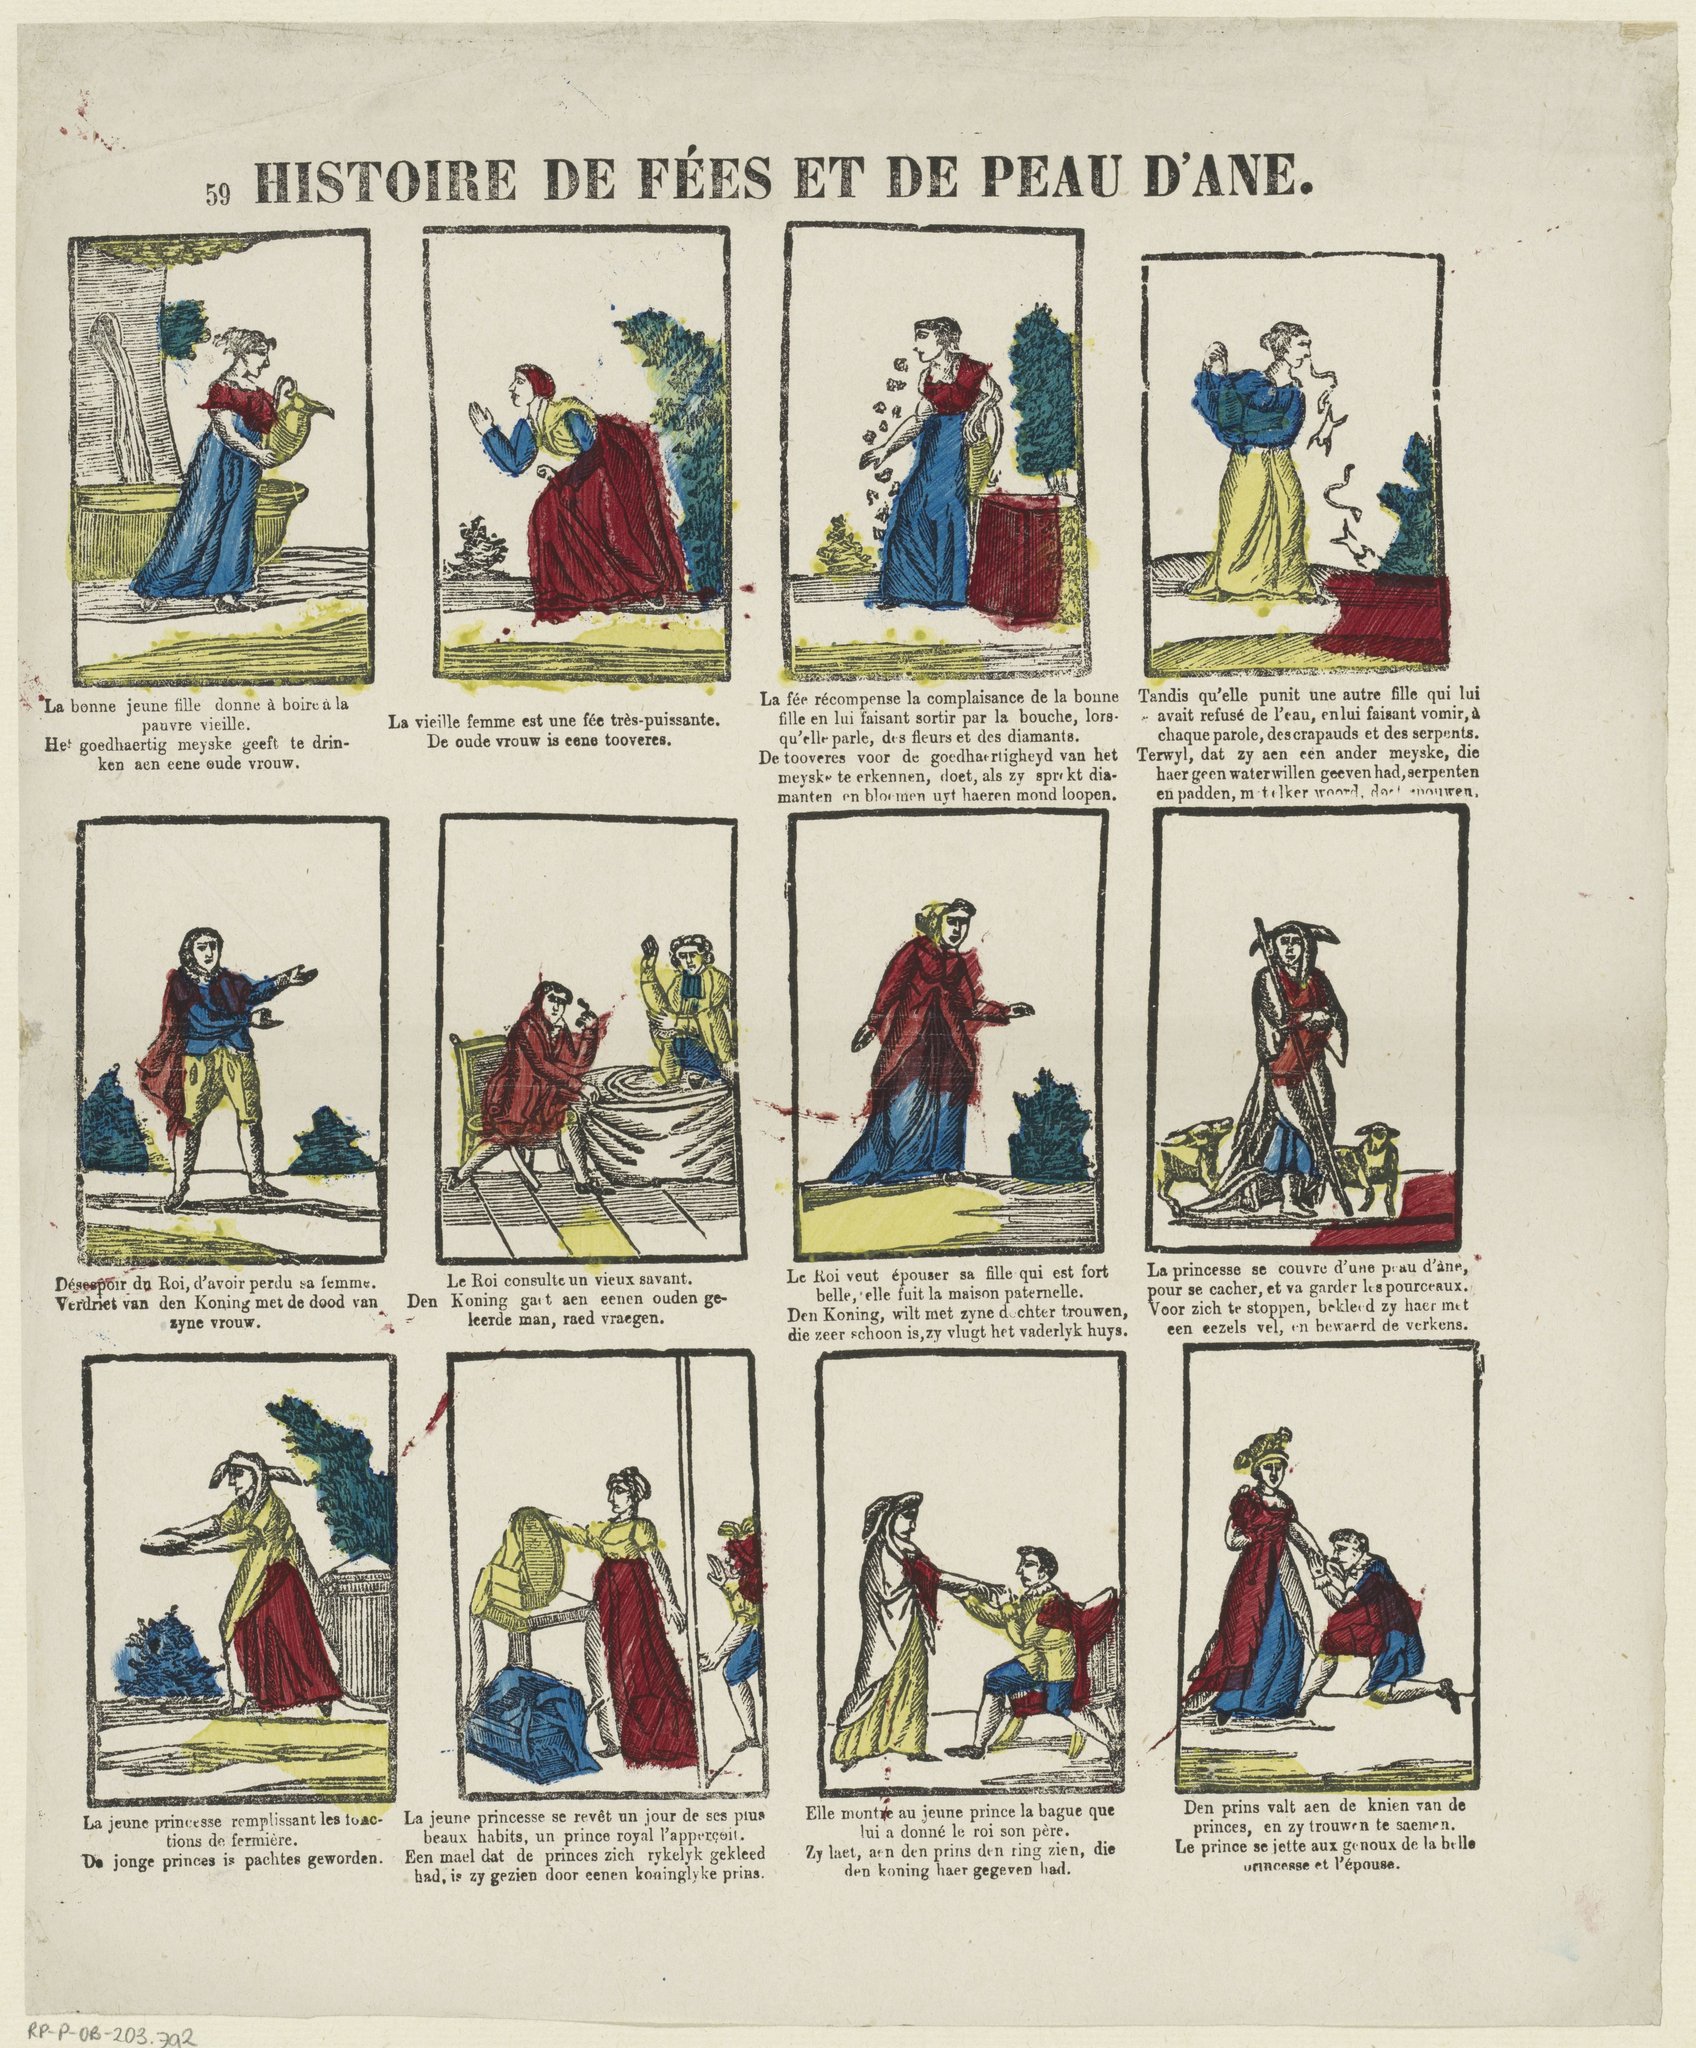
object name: popular print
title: Histoire de fées et de peau d'ane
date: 1827-1894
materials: paper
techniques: colour, letterpress printing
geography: schaarbeek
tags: magic, supernaturalism, occultism, princess, tales and fairy tales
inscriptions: collector's mark: Lugt 2760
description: Blad met 12 voorstellingen. Boven vier voorstellingen over twee meiden die betoverd worden door een tovenares. Onder acht voorstellingen over een princes die zich verstopt door het aantrekken van de huid van een ezel. Onder elke afbeelding een onderschrift in het Nederlands en in het Frans. Genummerd linksboven: 59.